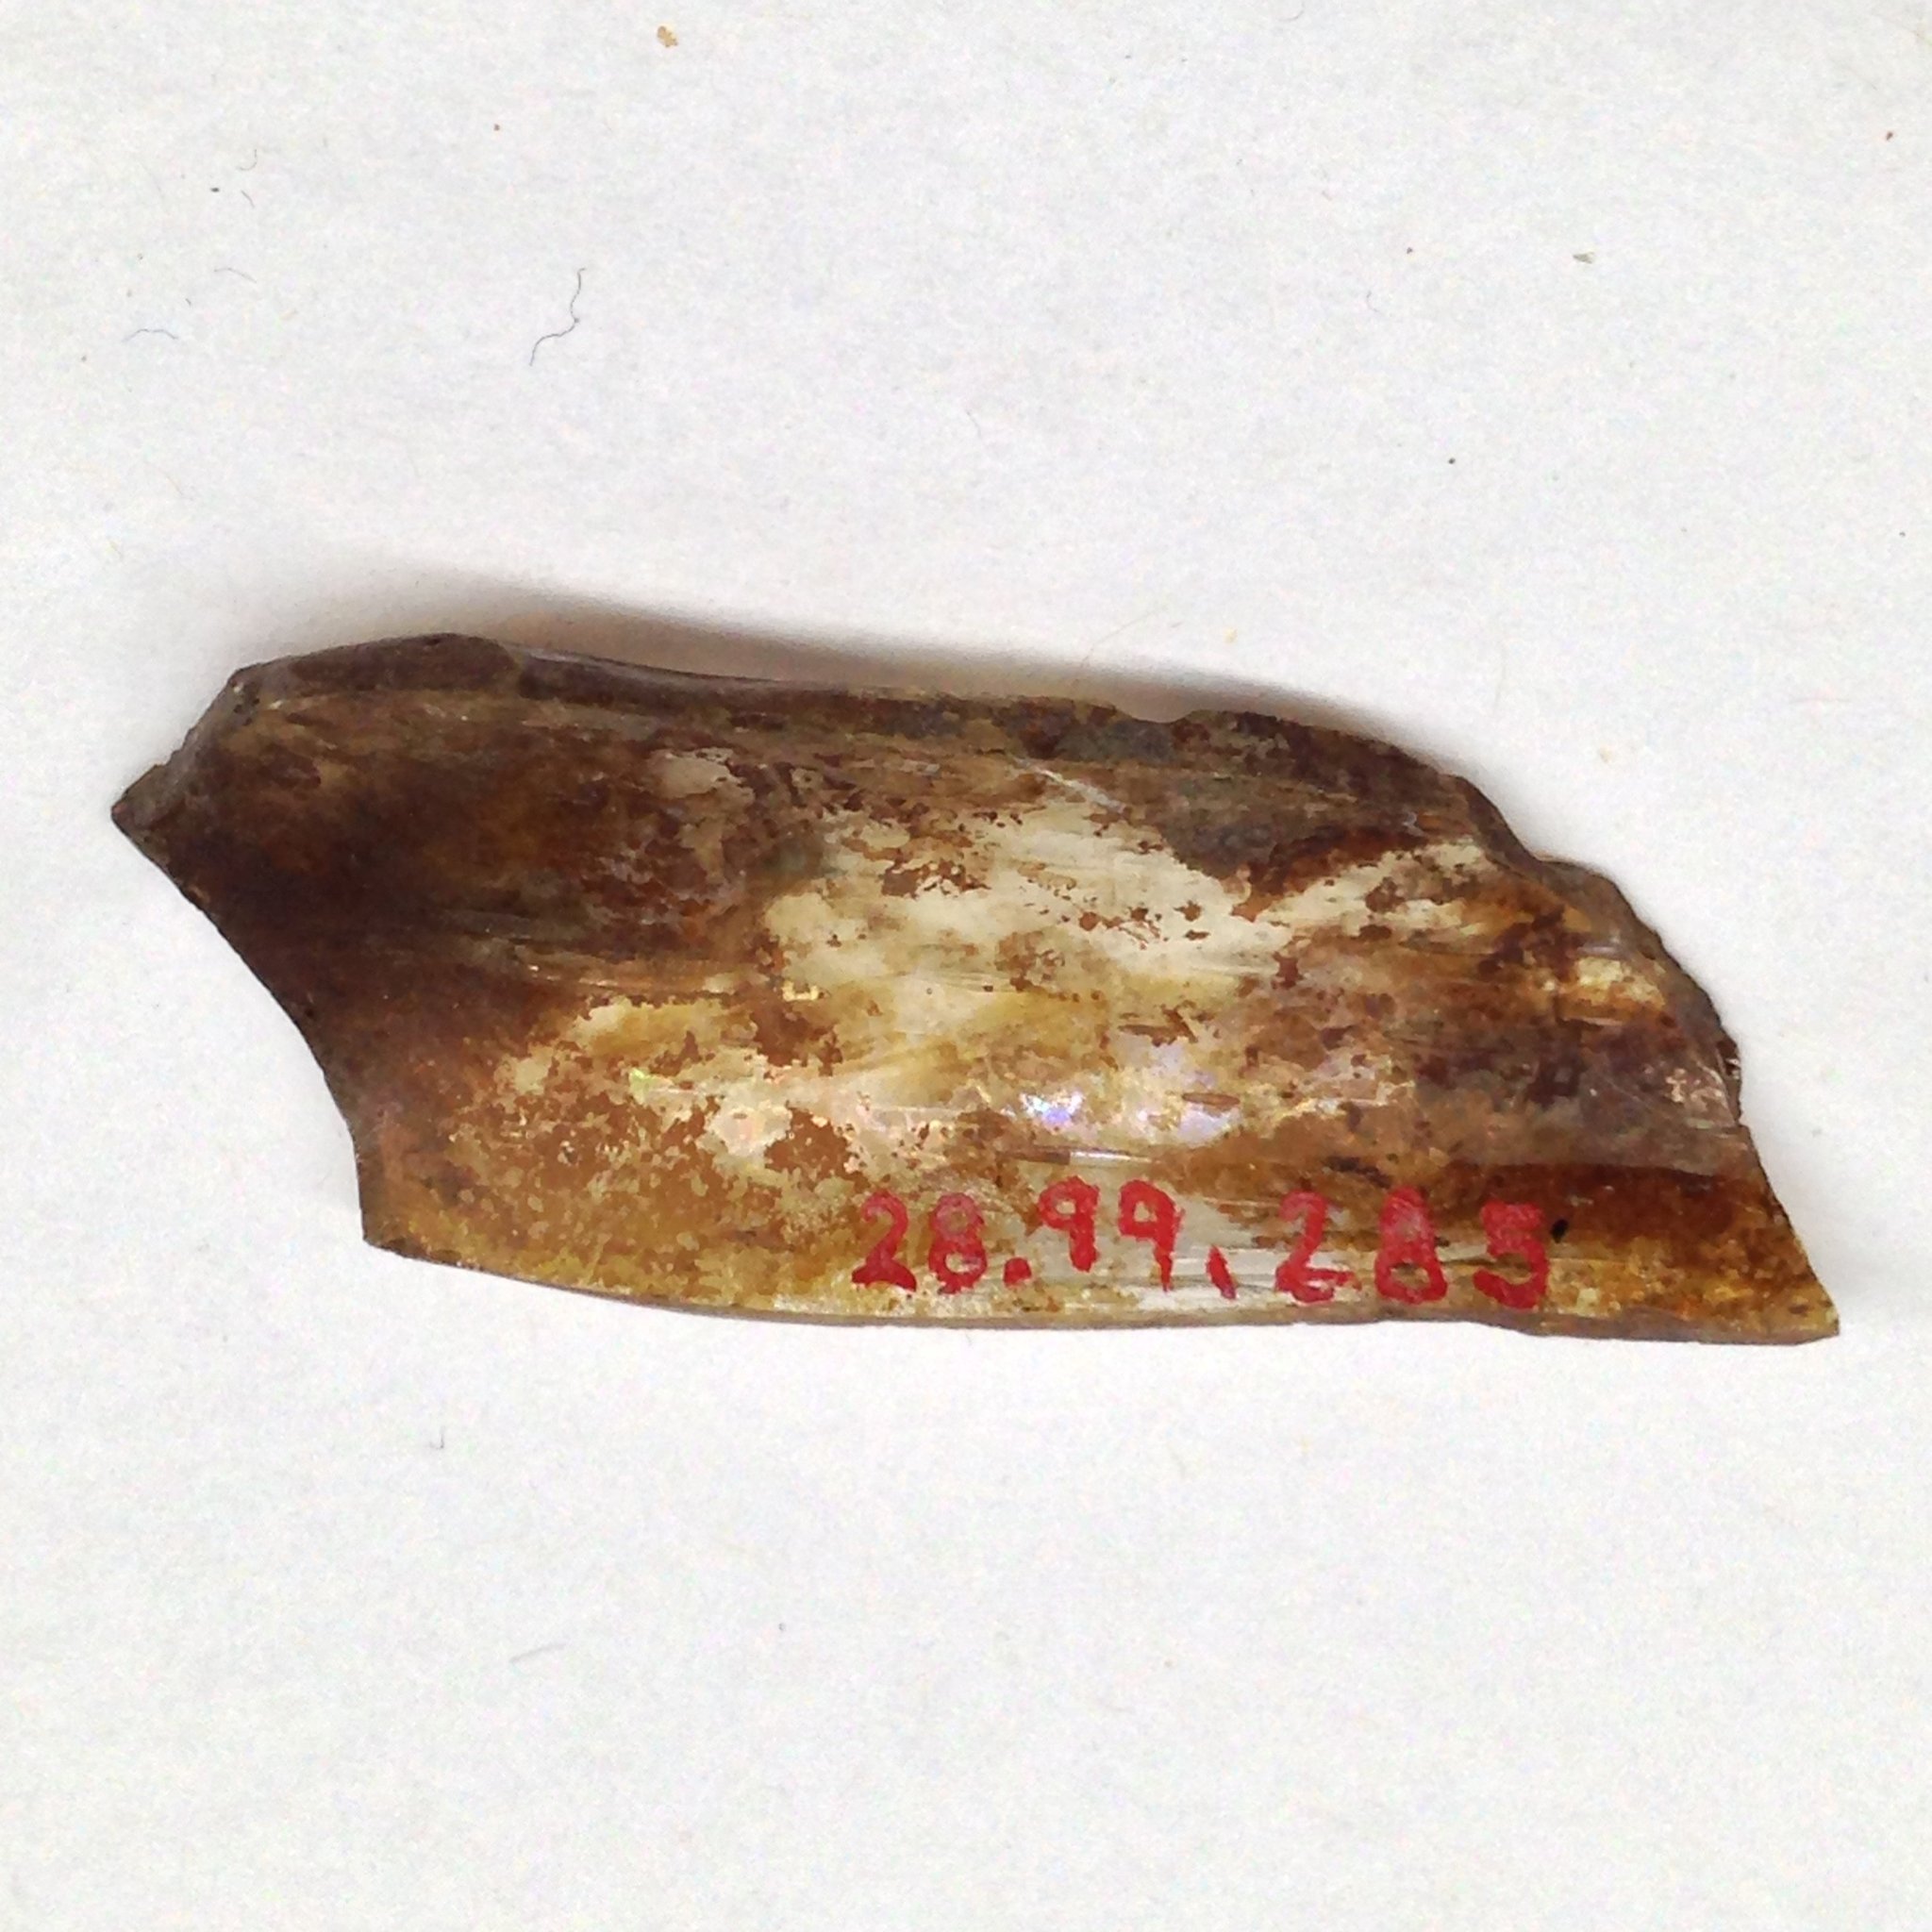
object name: fragment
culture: european or middle eastern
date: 1150-1250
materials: ceramic, glass